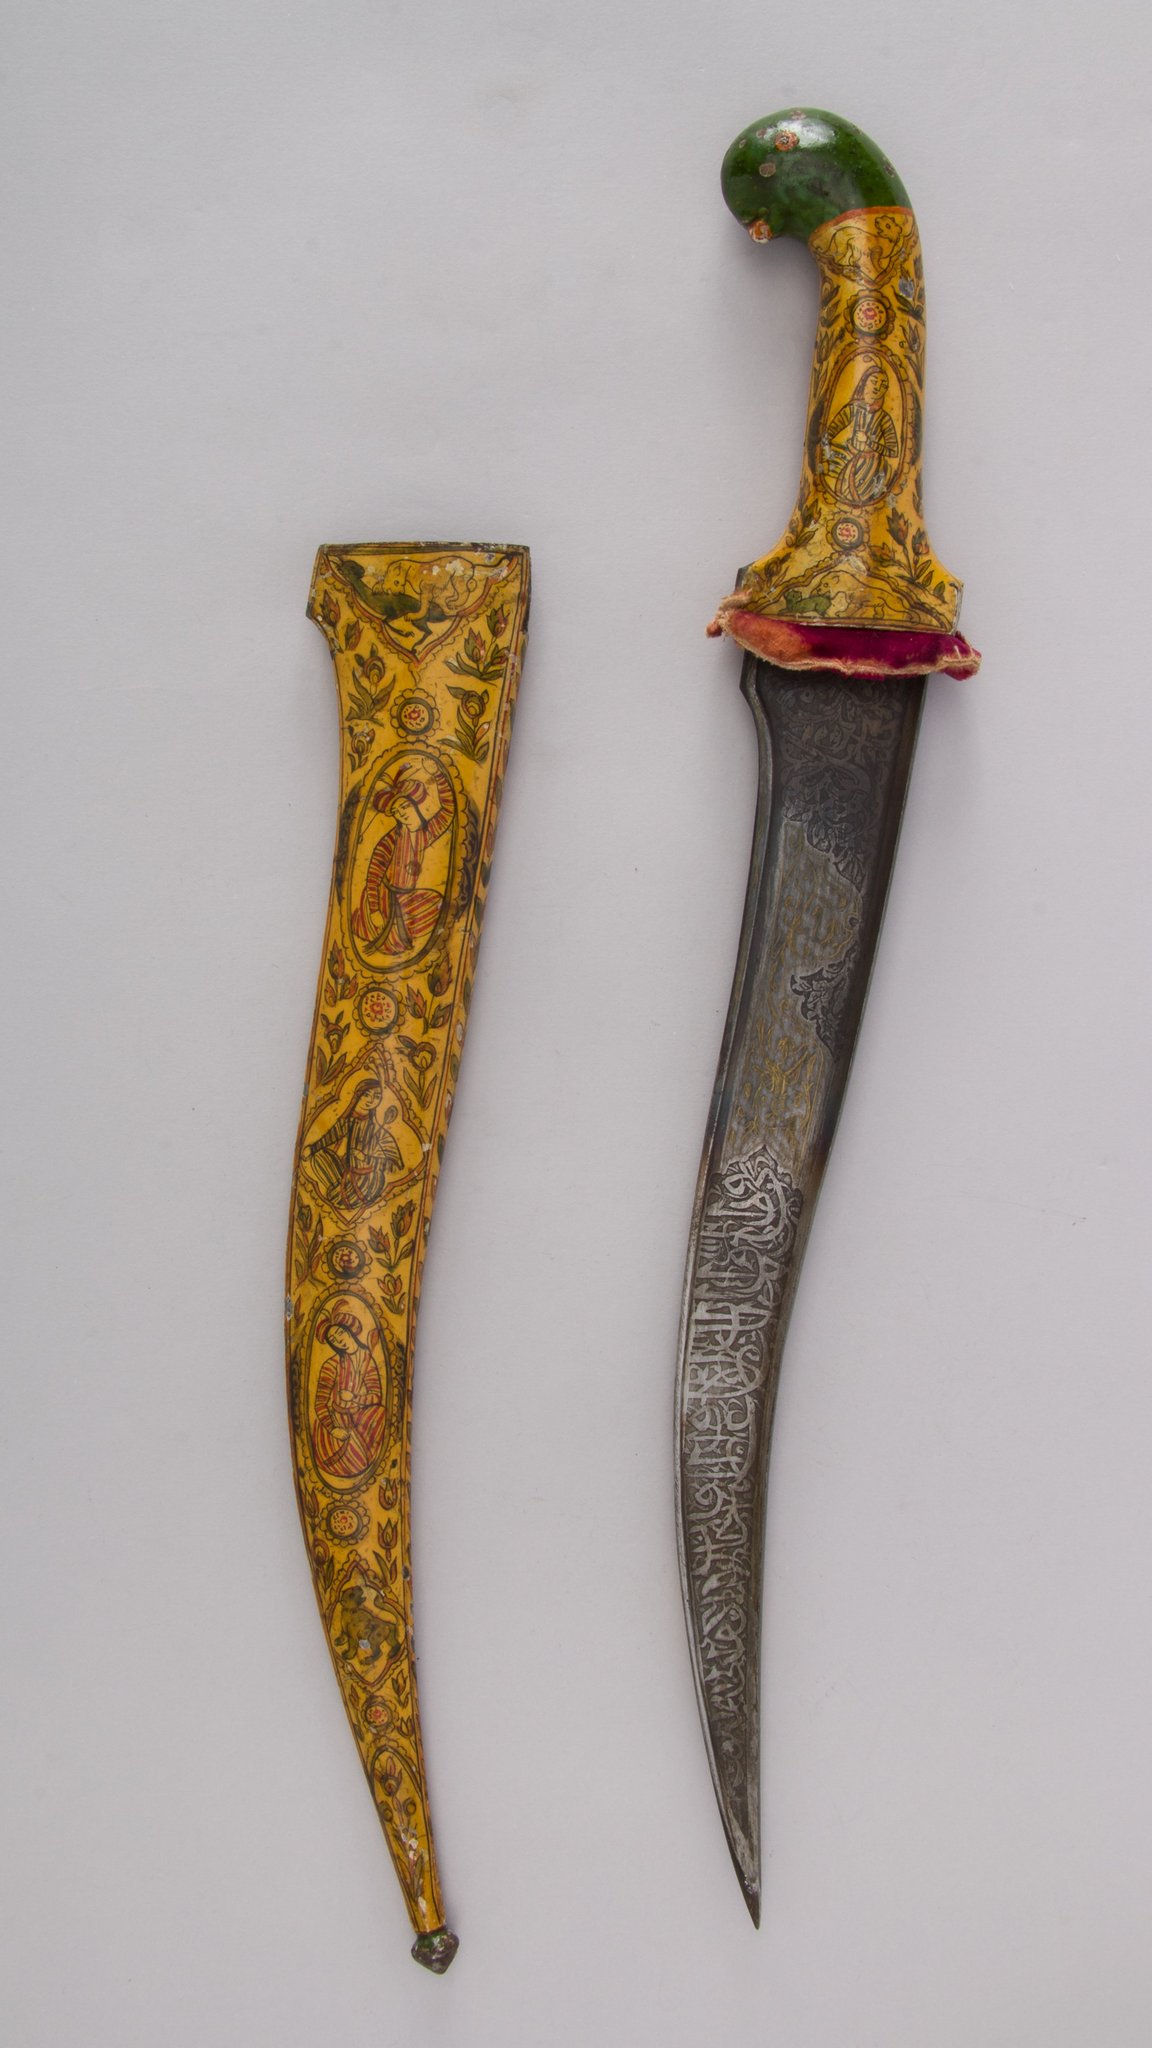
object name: dagger with sheath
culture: persian, qajar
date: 1801-1900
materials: iron, lacquer, velvet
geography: iran